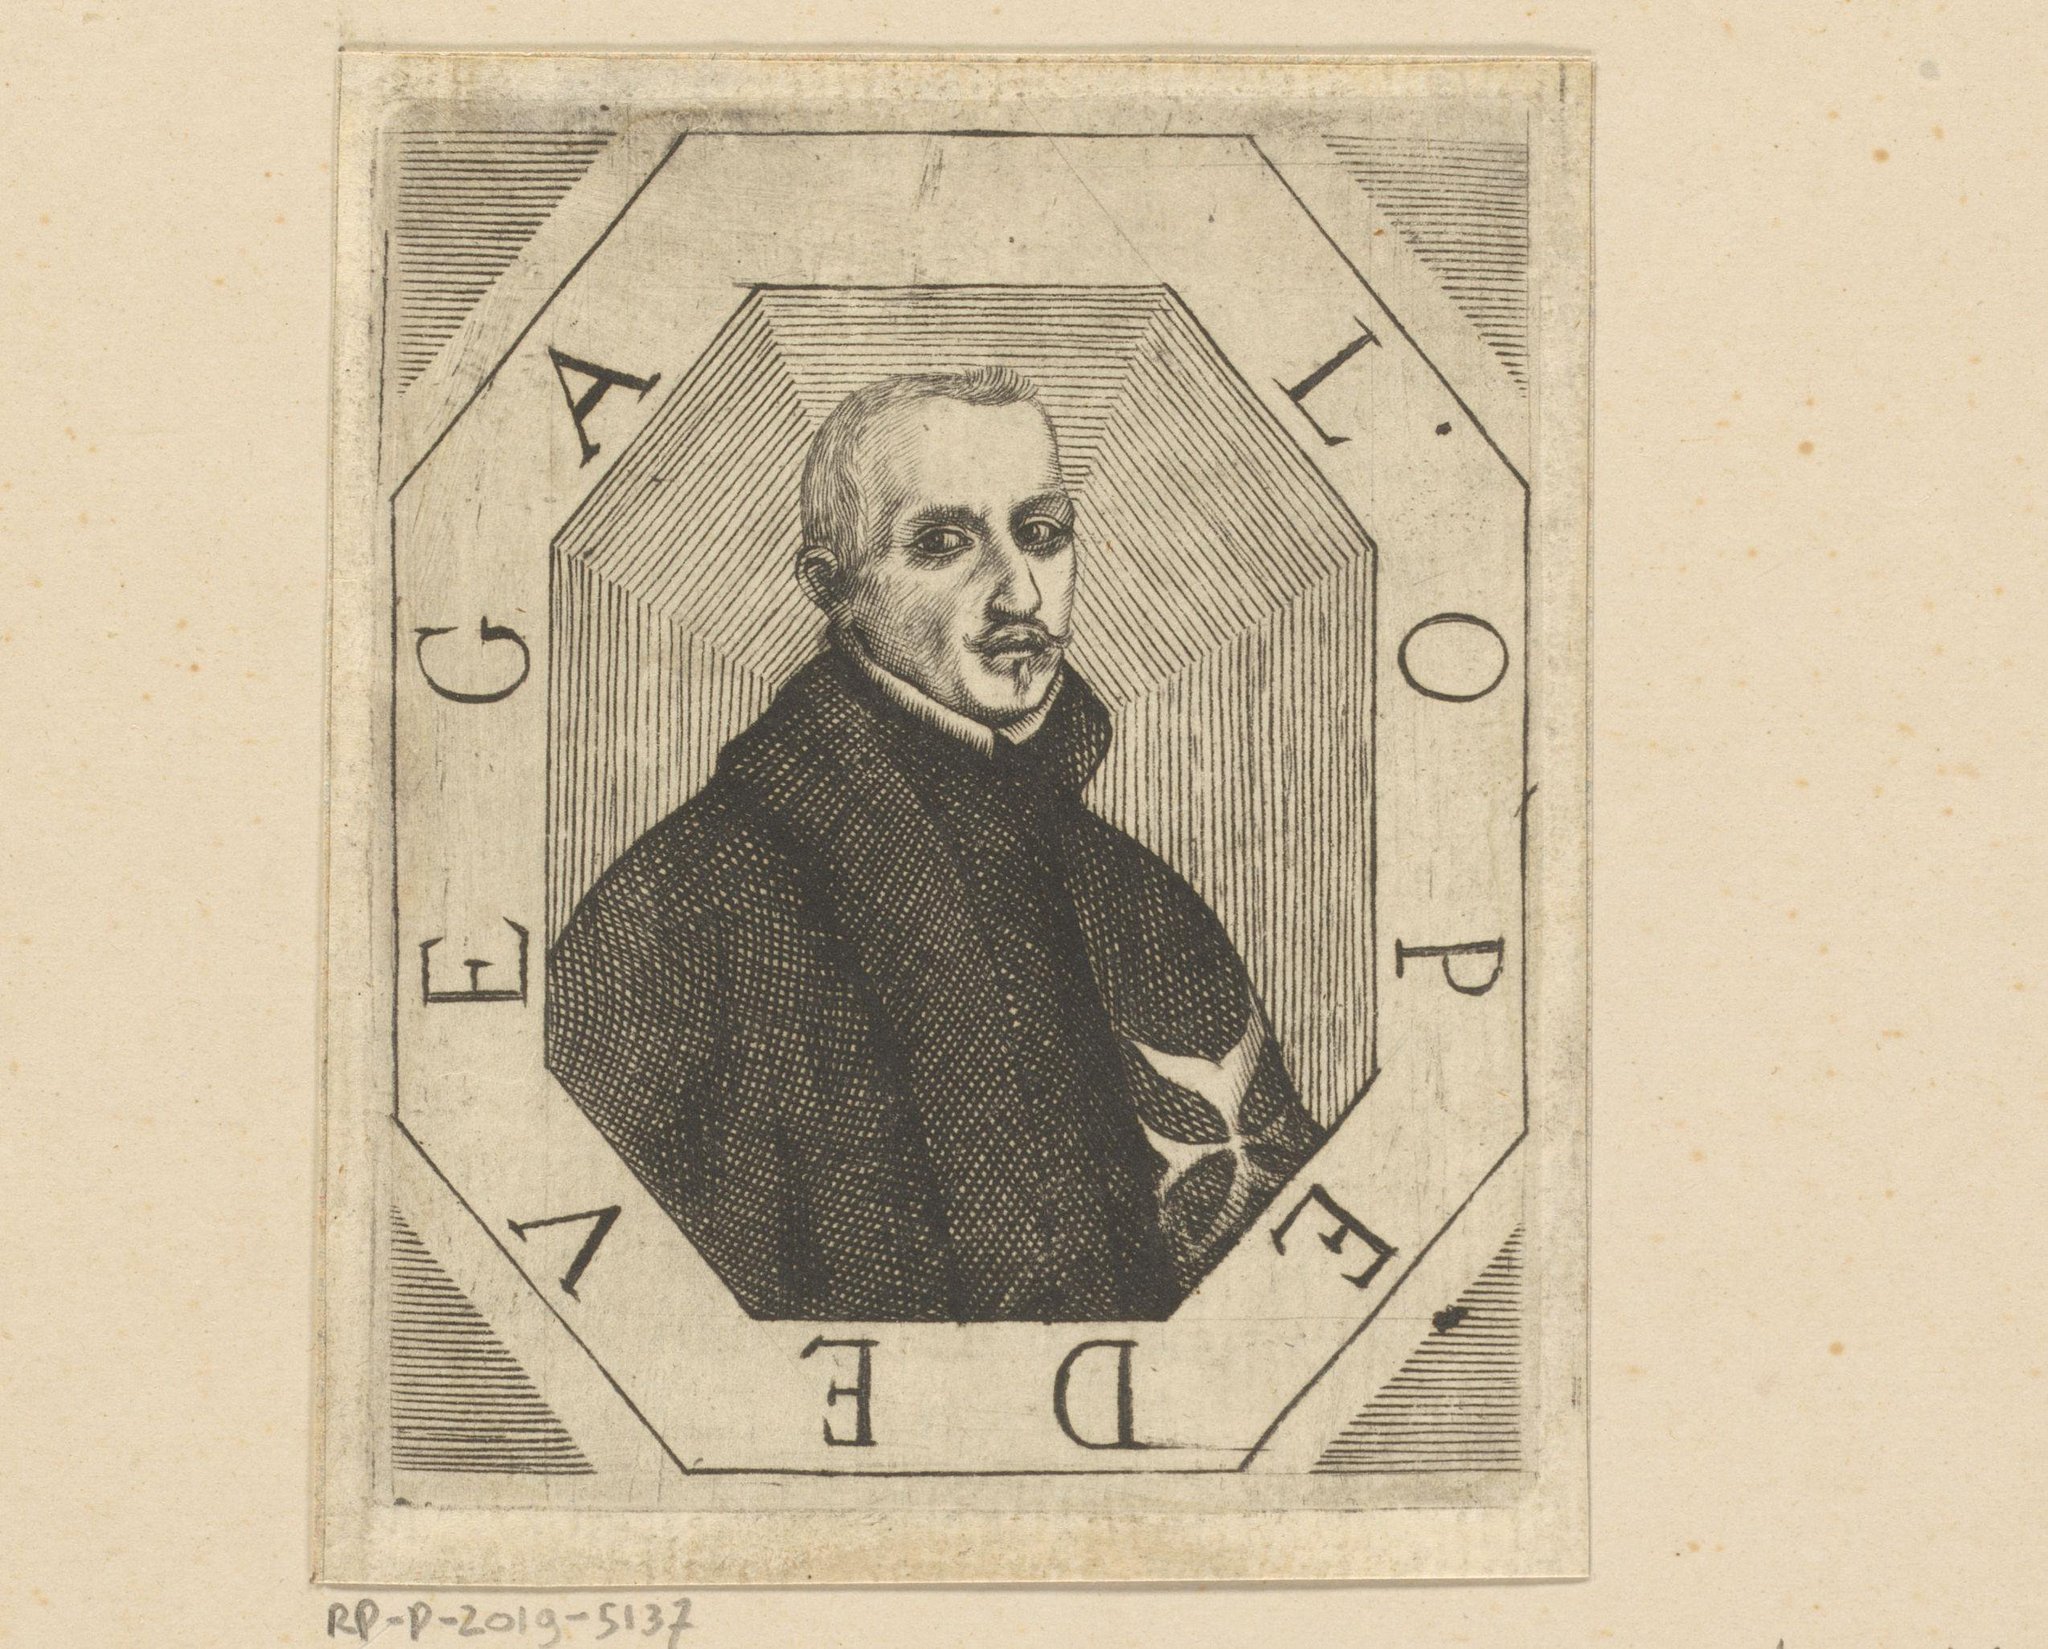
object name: print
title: Portret van Félix Lope de Vega Carpio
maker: Anonymous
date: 1666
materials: paper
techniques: engraving, letterpress printing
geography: venice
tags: historical persons, portrait of a writer, writer, poet, author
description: Prent uit: Crasso, Lorenzo. Elogii degli huomini letterati scritti. Venetië: Combi & la Noù, 1666, dl. 2, p. 109.